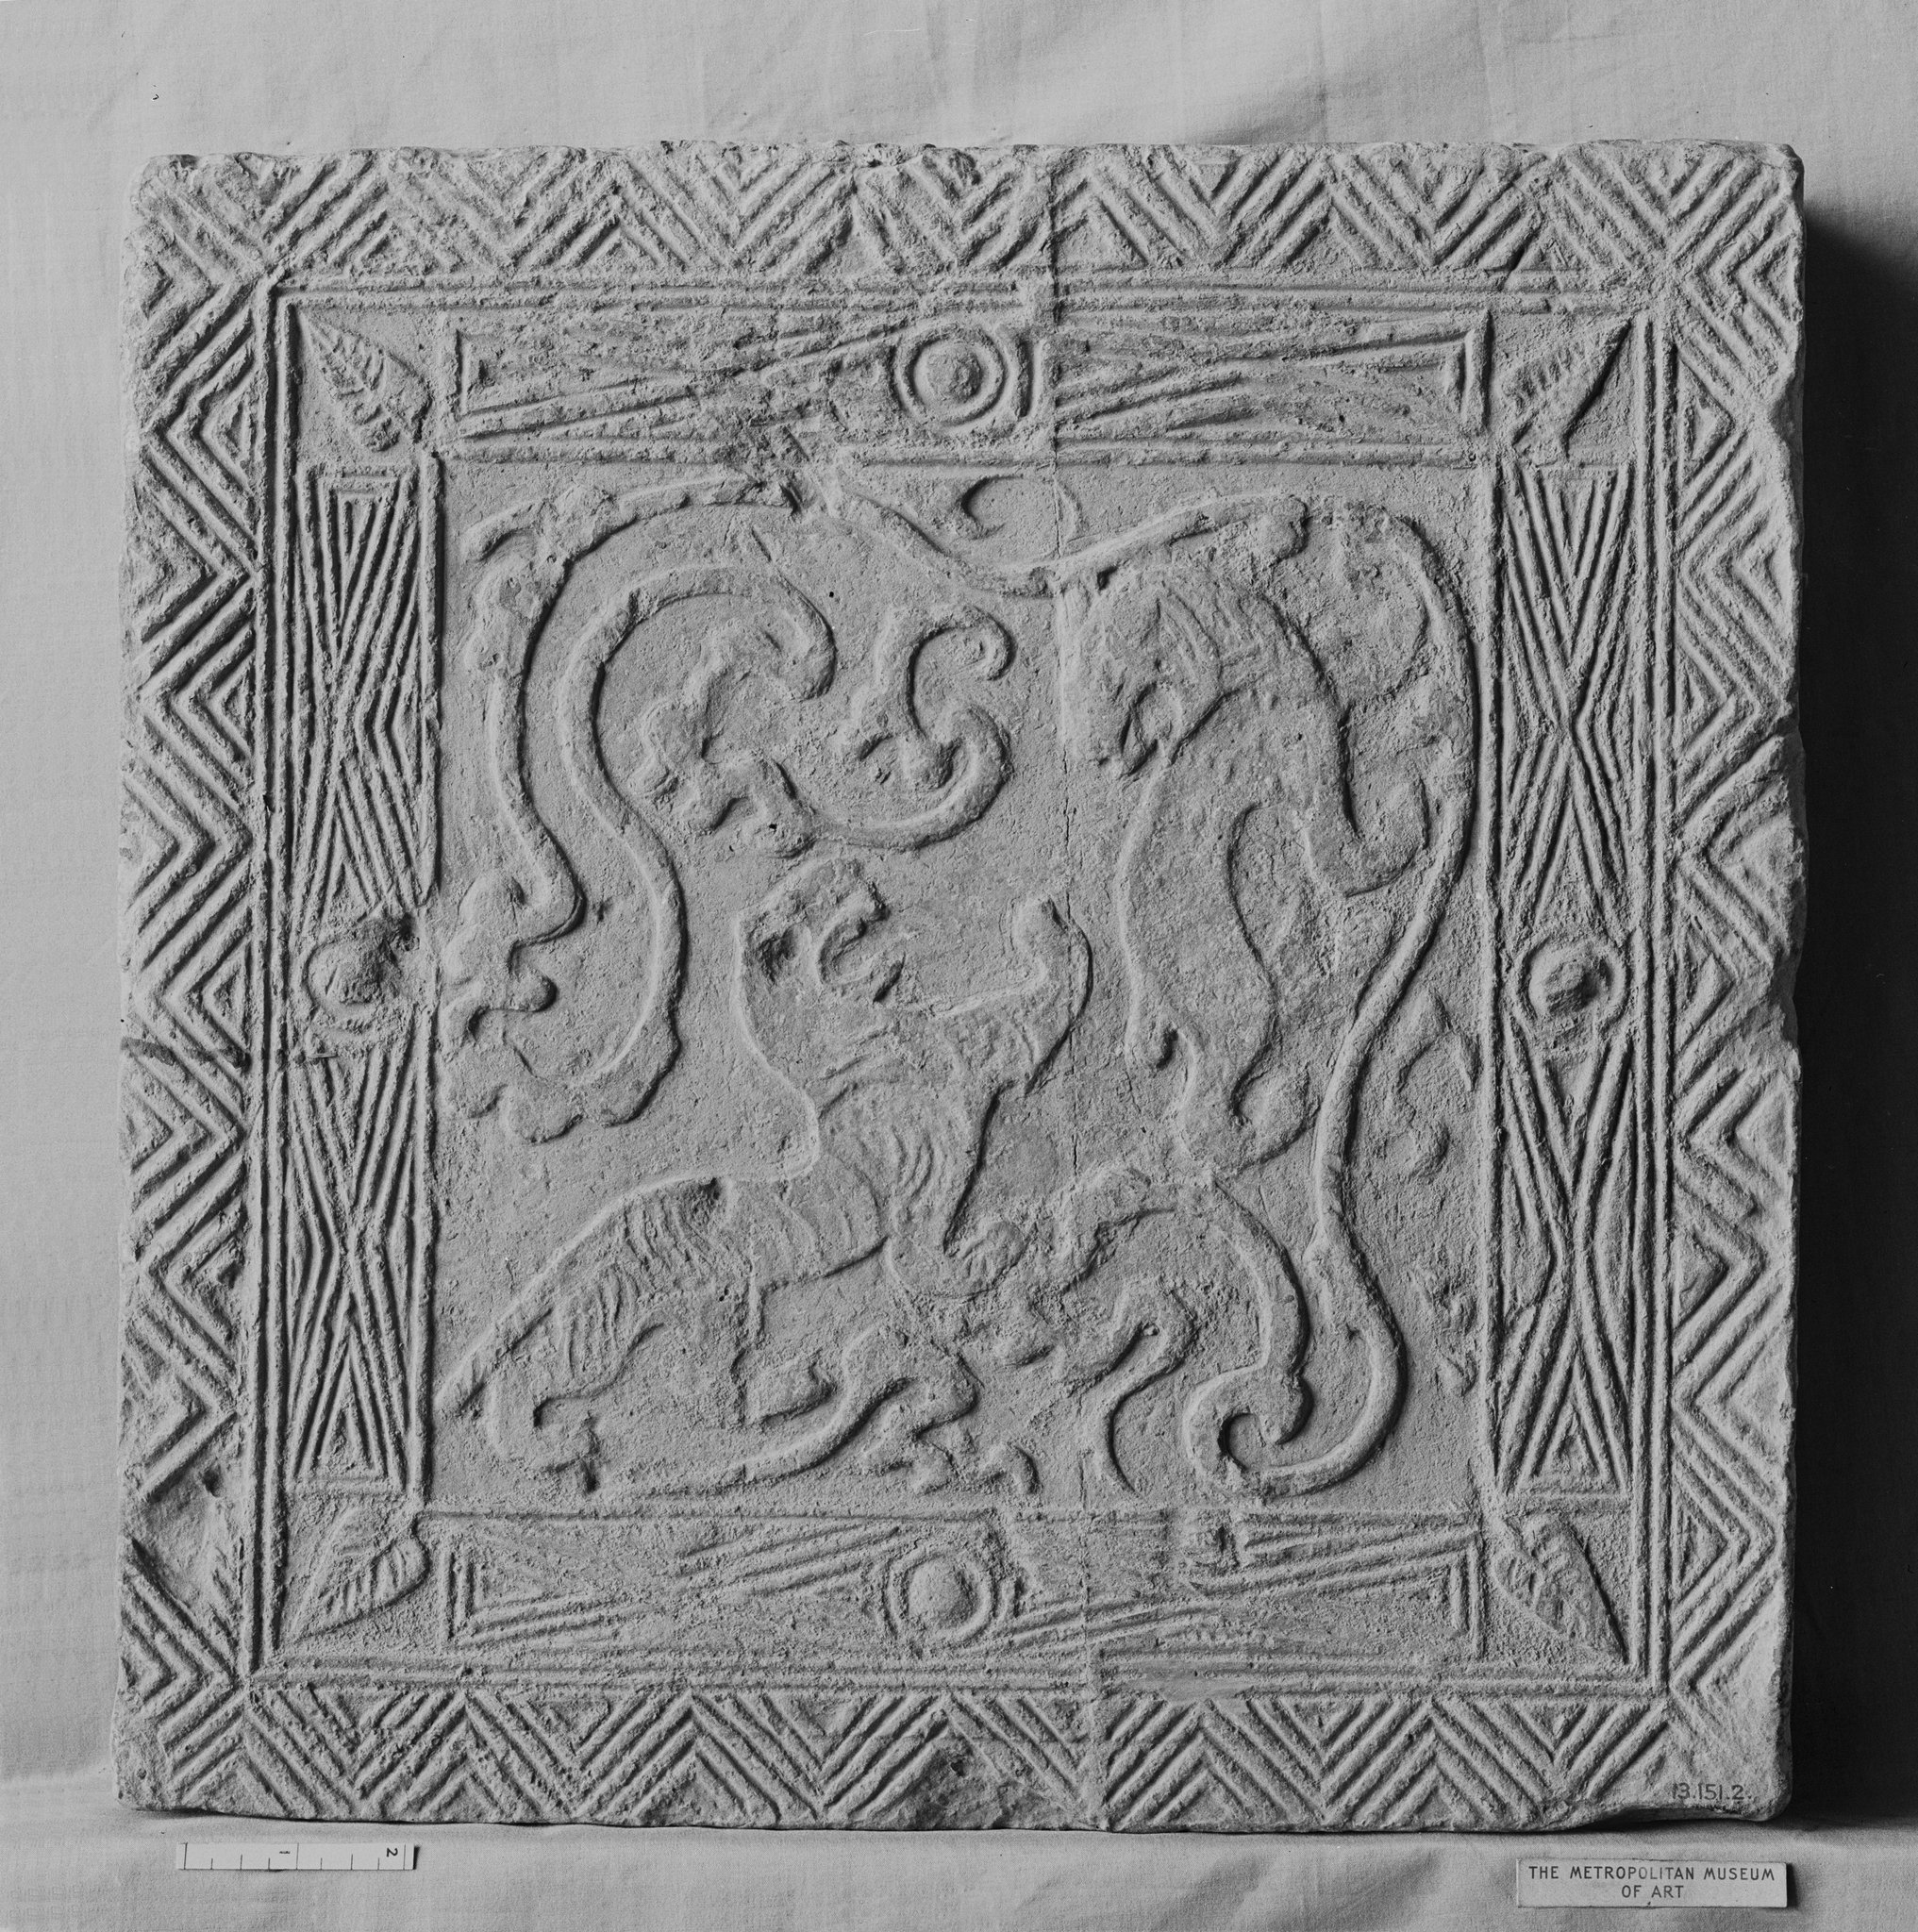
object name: mural tile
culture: chinese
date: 206 BCE-220 CE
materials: terracotta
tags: animals,murals